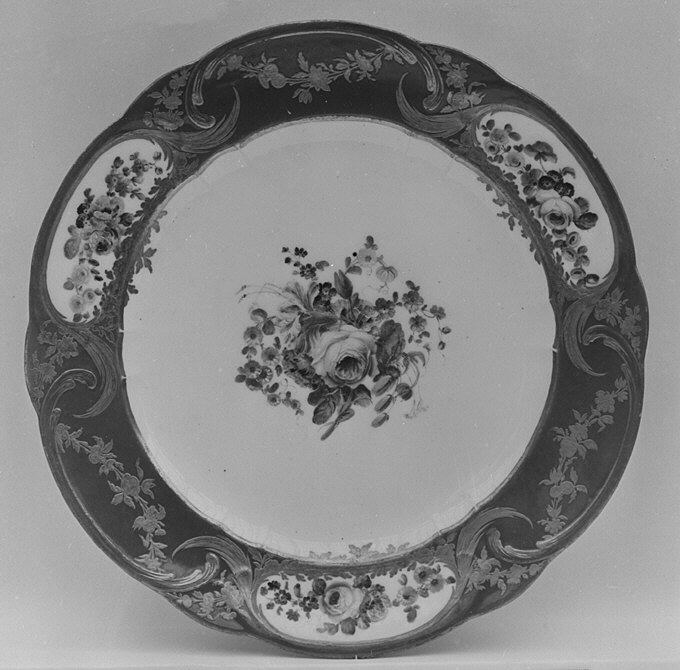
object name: plate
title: Plate (Assiette à palmes) (1 of 102) (part of a service)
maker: sèvres manufactory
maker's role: manufactory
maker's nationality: french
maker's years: 1740-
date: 1767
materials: soft paste porcelain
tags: roses